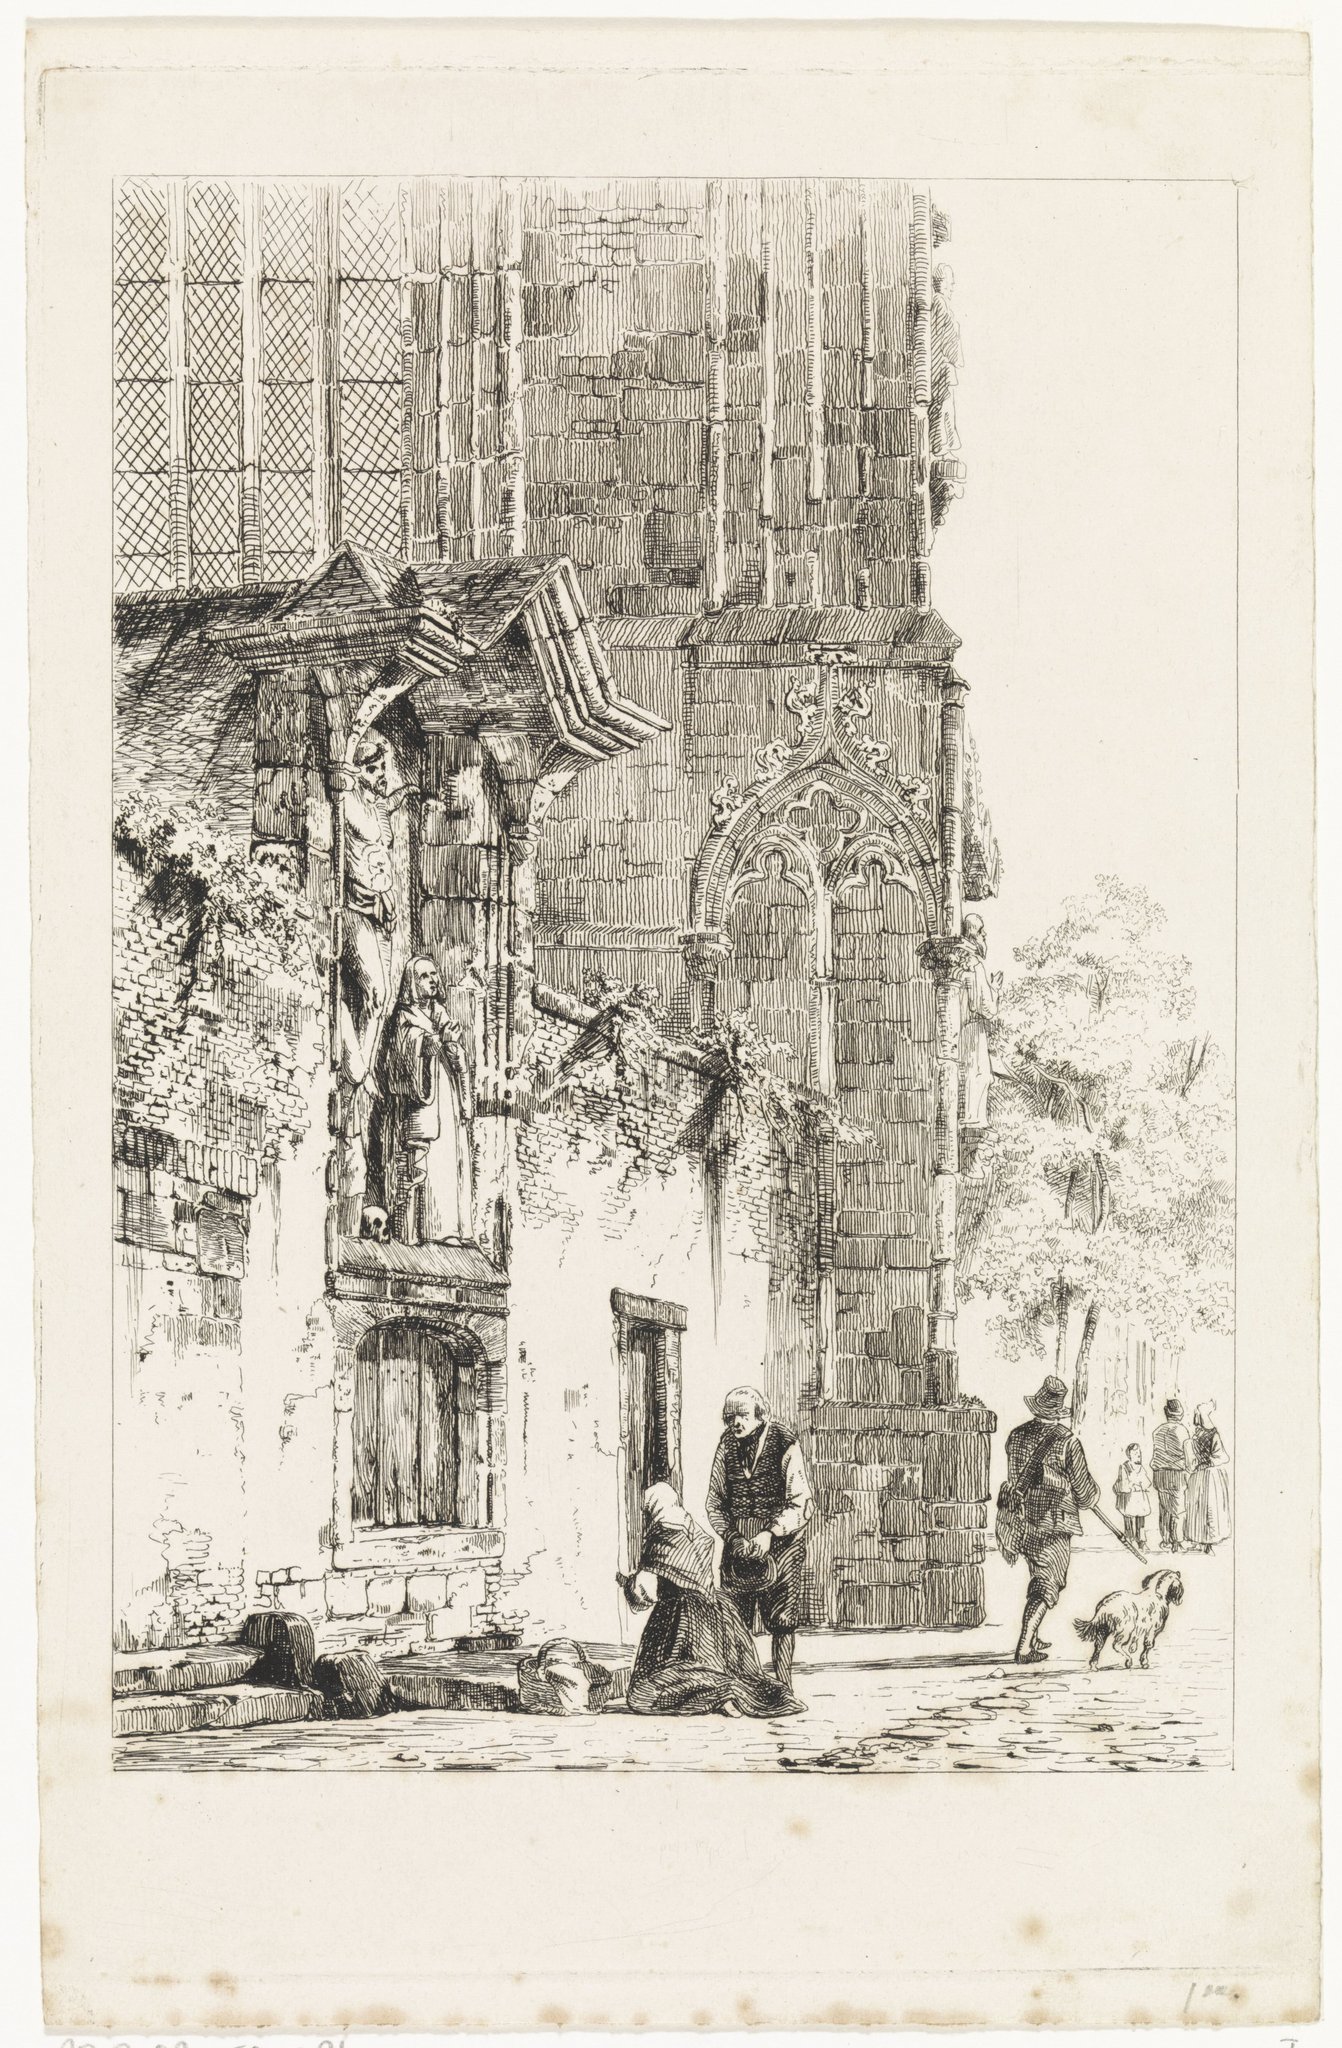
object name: print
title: Vrouw knielend voor een kapelletje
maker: cornelis springer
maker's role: draughtsman, painter, print maker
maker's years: 1817-1891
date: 1844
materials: paper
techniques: etching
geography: amsterdam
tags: parts of church exterior and annexes: chapel, crucifix ~ personal devotion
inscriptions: collector's mark: Lugt 2228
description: Een vrouw knielt voor een kappelletje, waarin een kruisbeeld hangt, aan de buitenzijde van een kerk. Een man staat met zijn hoed in de handen naast haar.